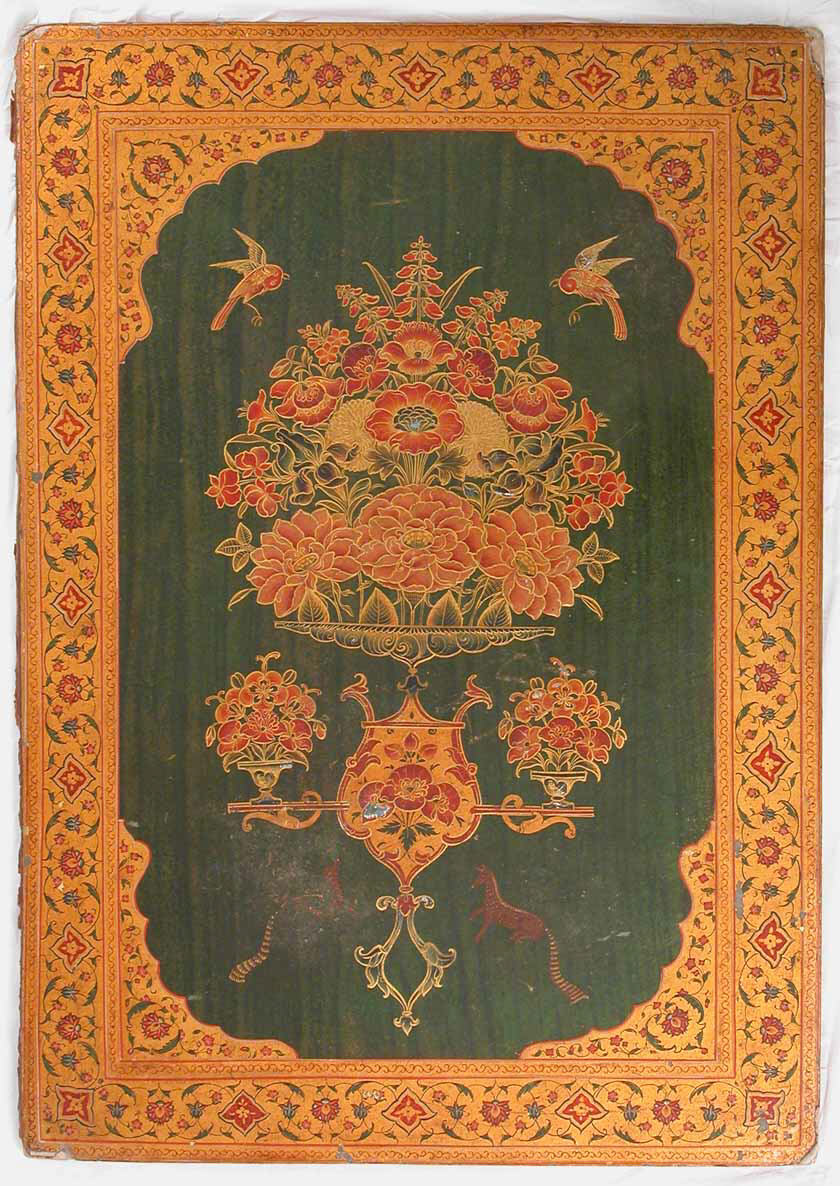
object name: bookbinding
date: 1601-1700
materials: board, leather, paper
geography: india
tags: birds,flowers